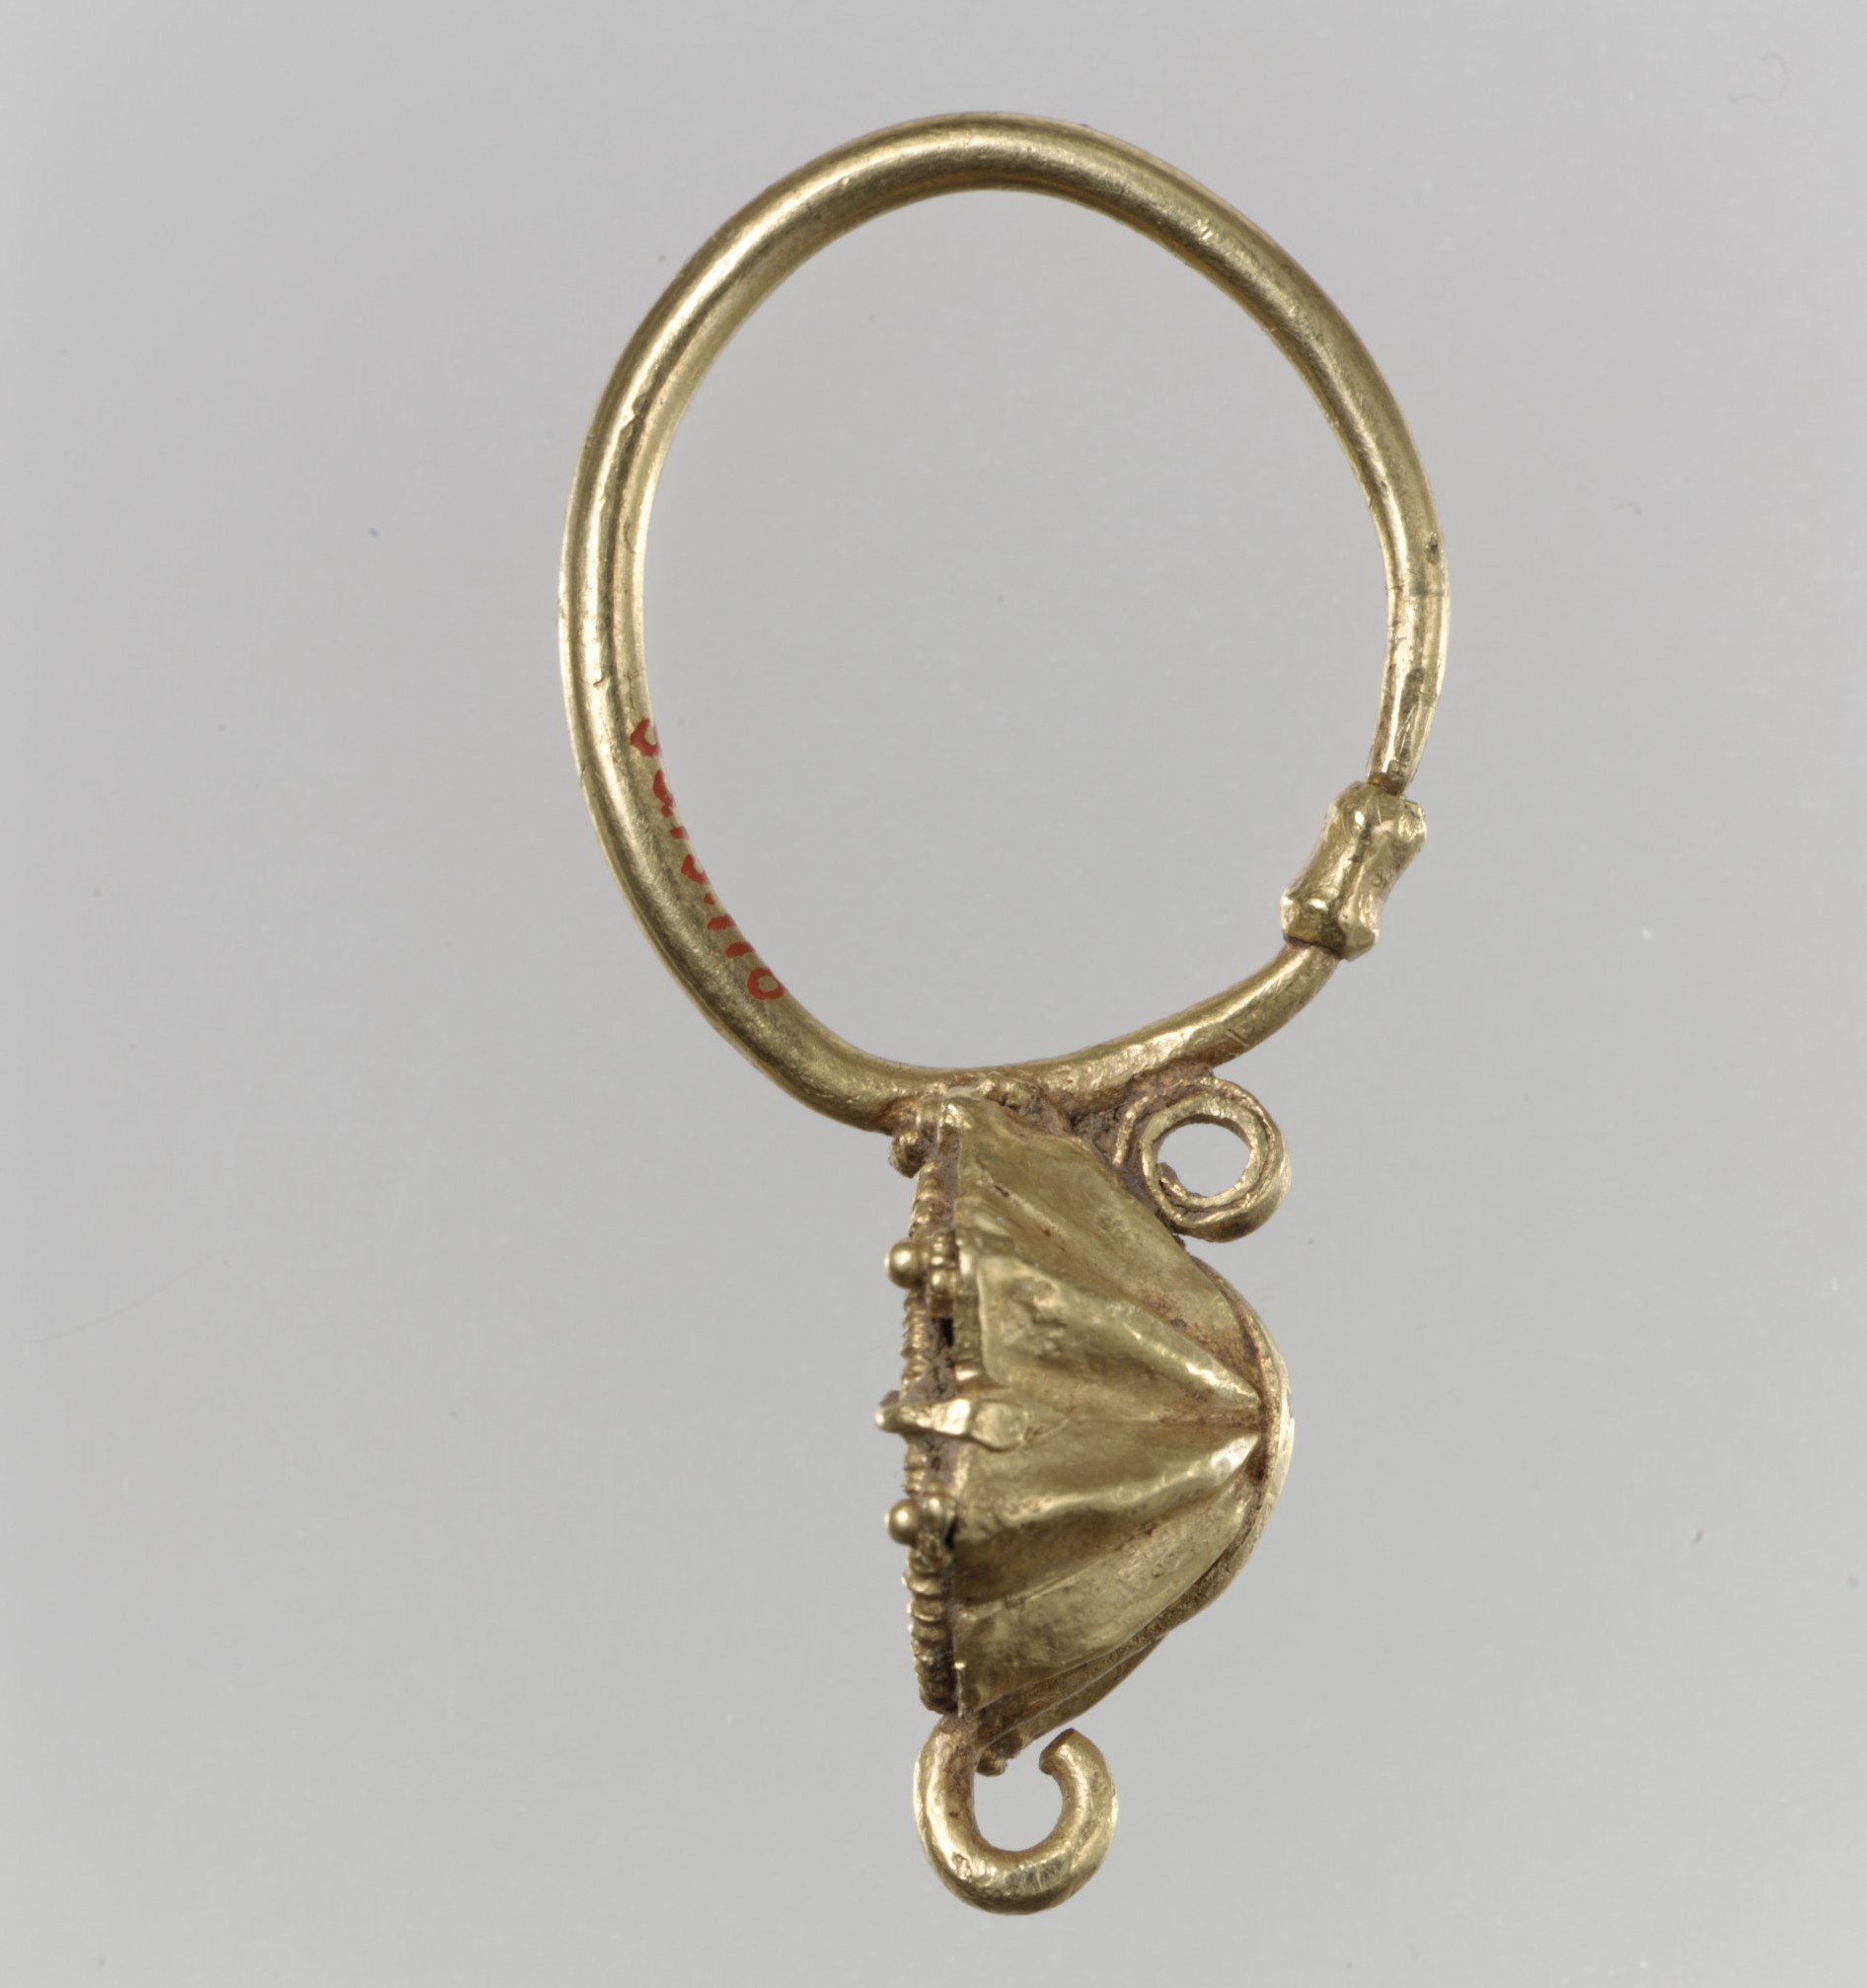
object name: earring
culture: byzantine or langobardic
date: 501-700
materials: gold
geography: italy